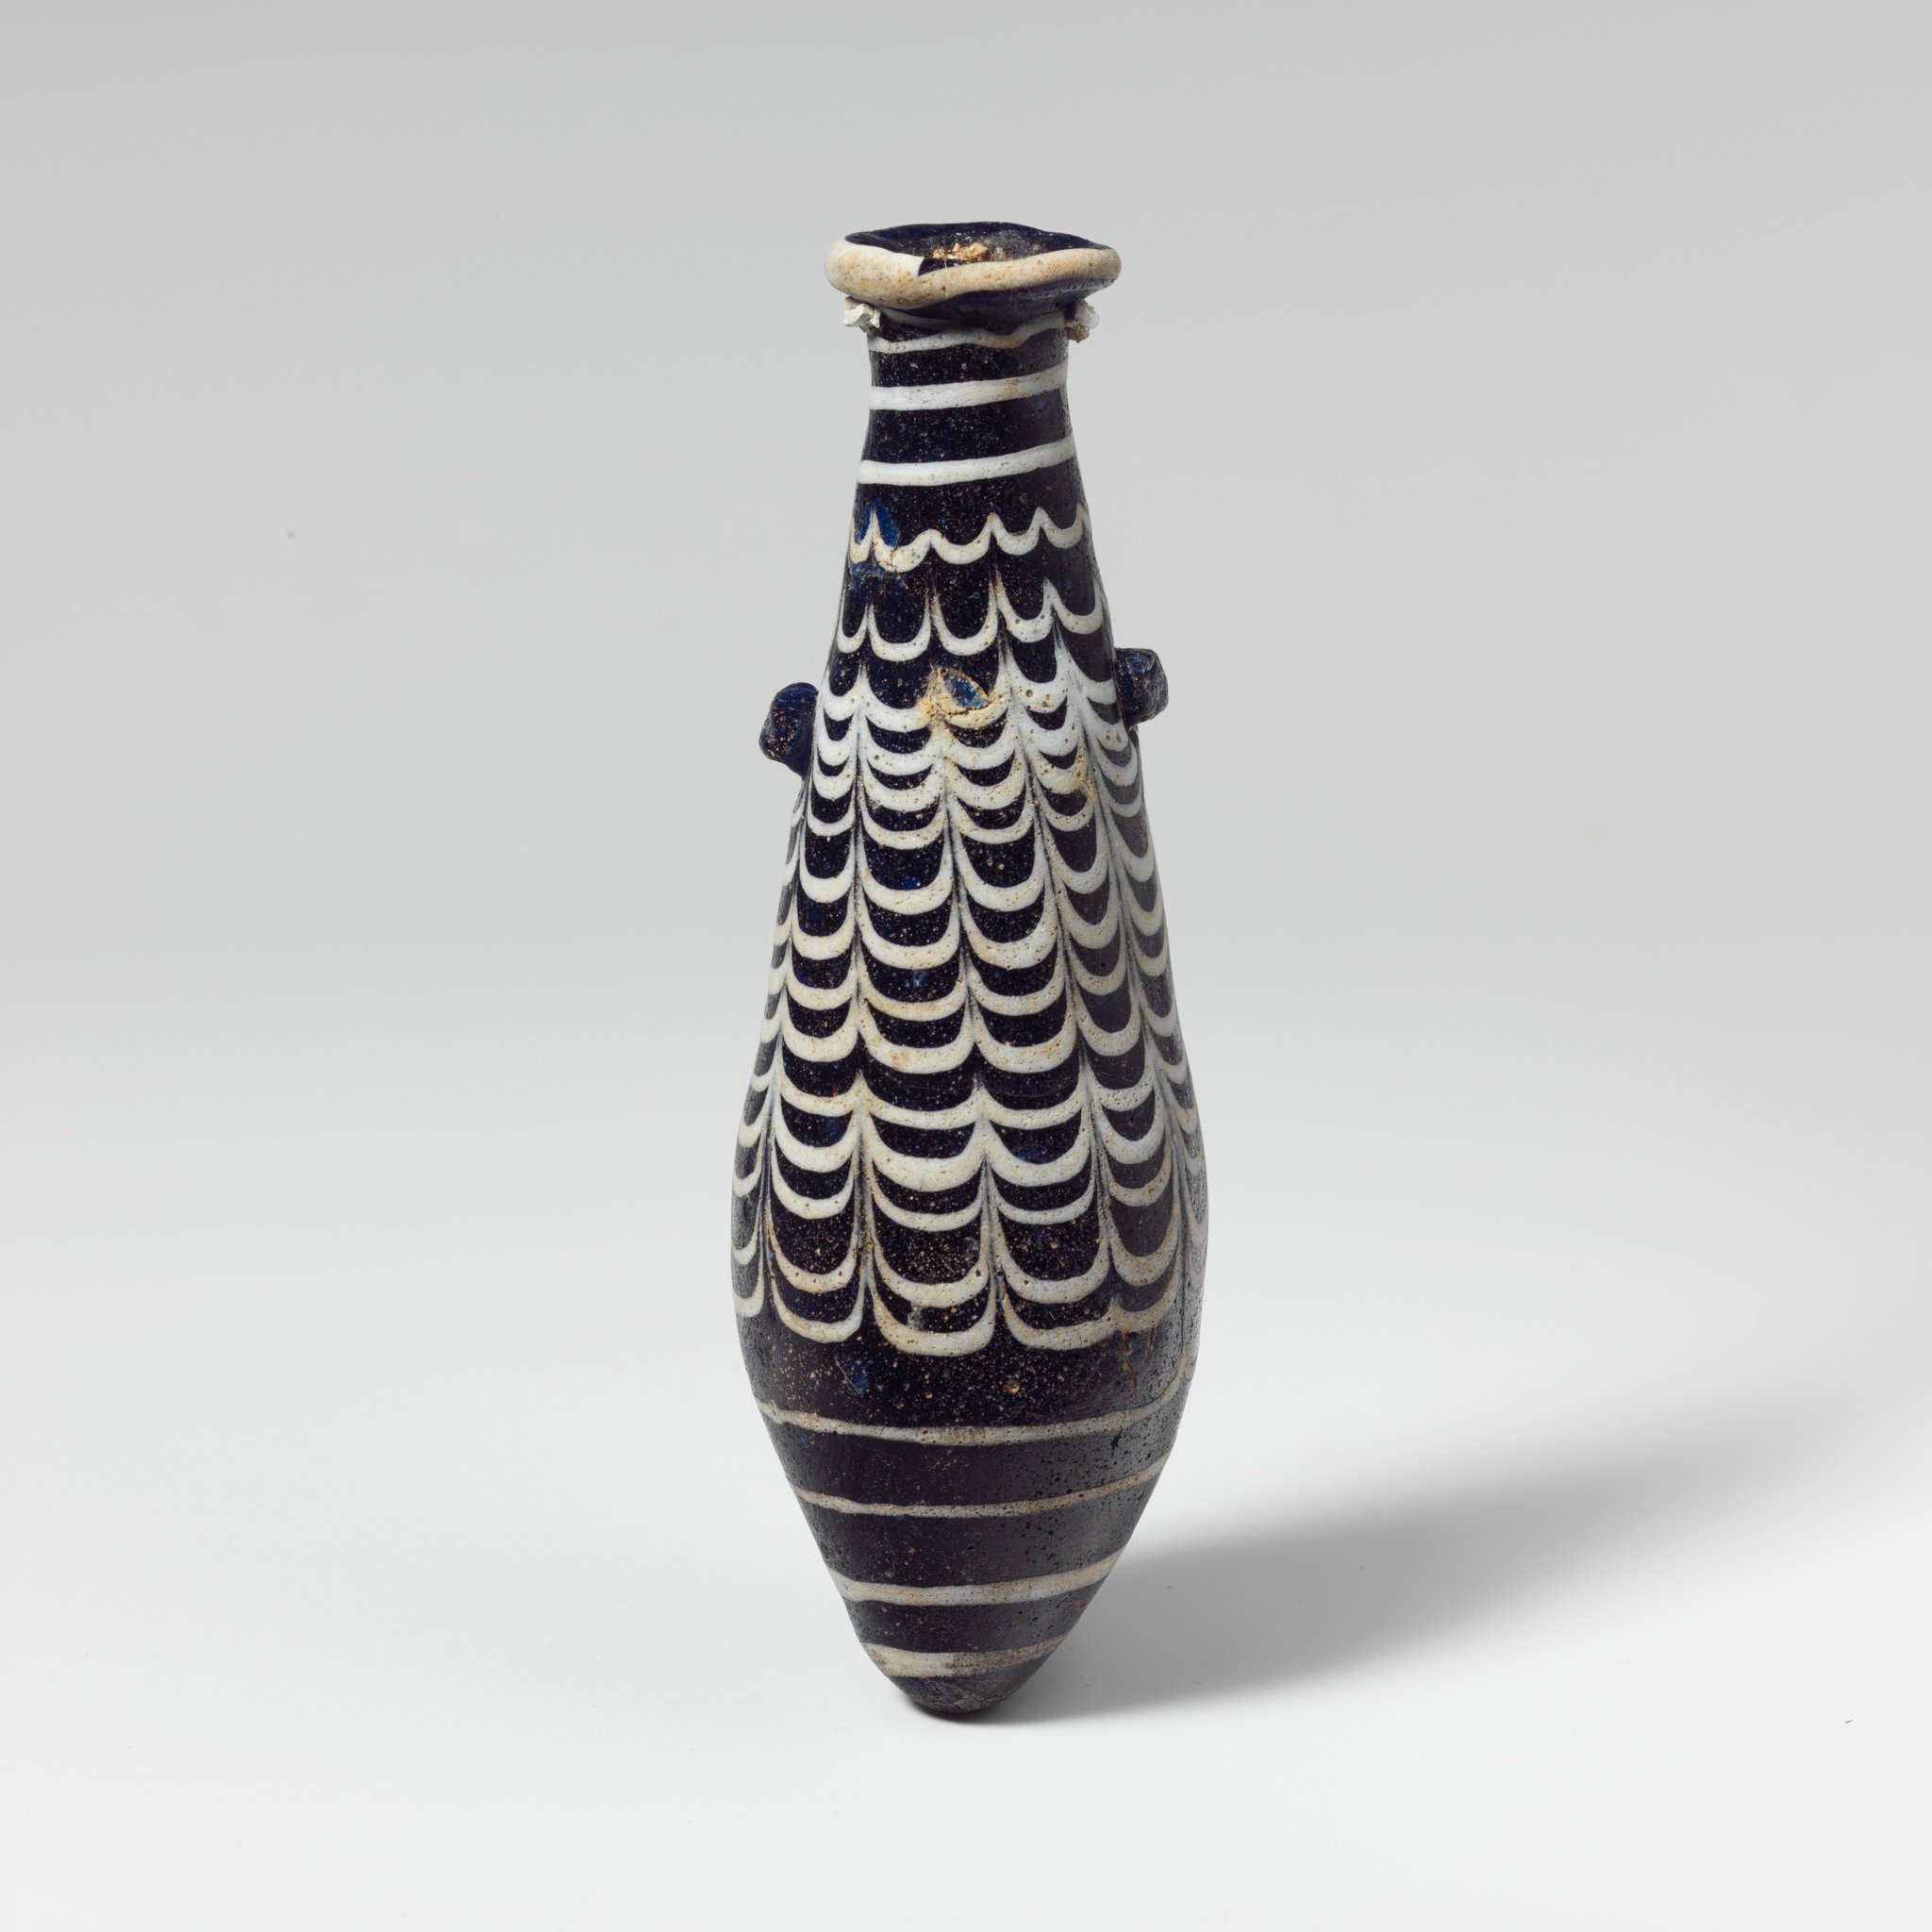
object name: alabastron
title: Glass alabastron (perfume bottle)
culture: greek, eastern mediterranean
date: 200-35 BCE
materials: glass